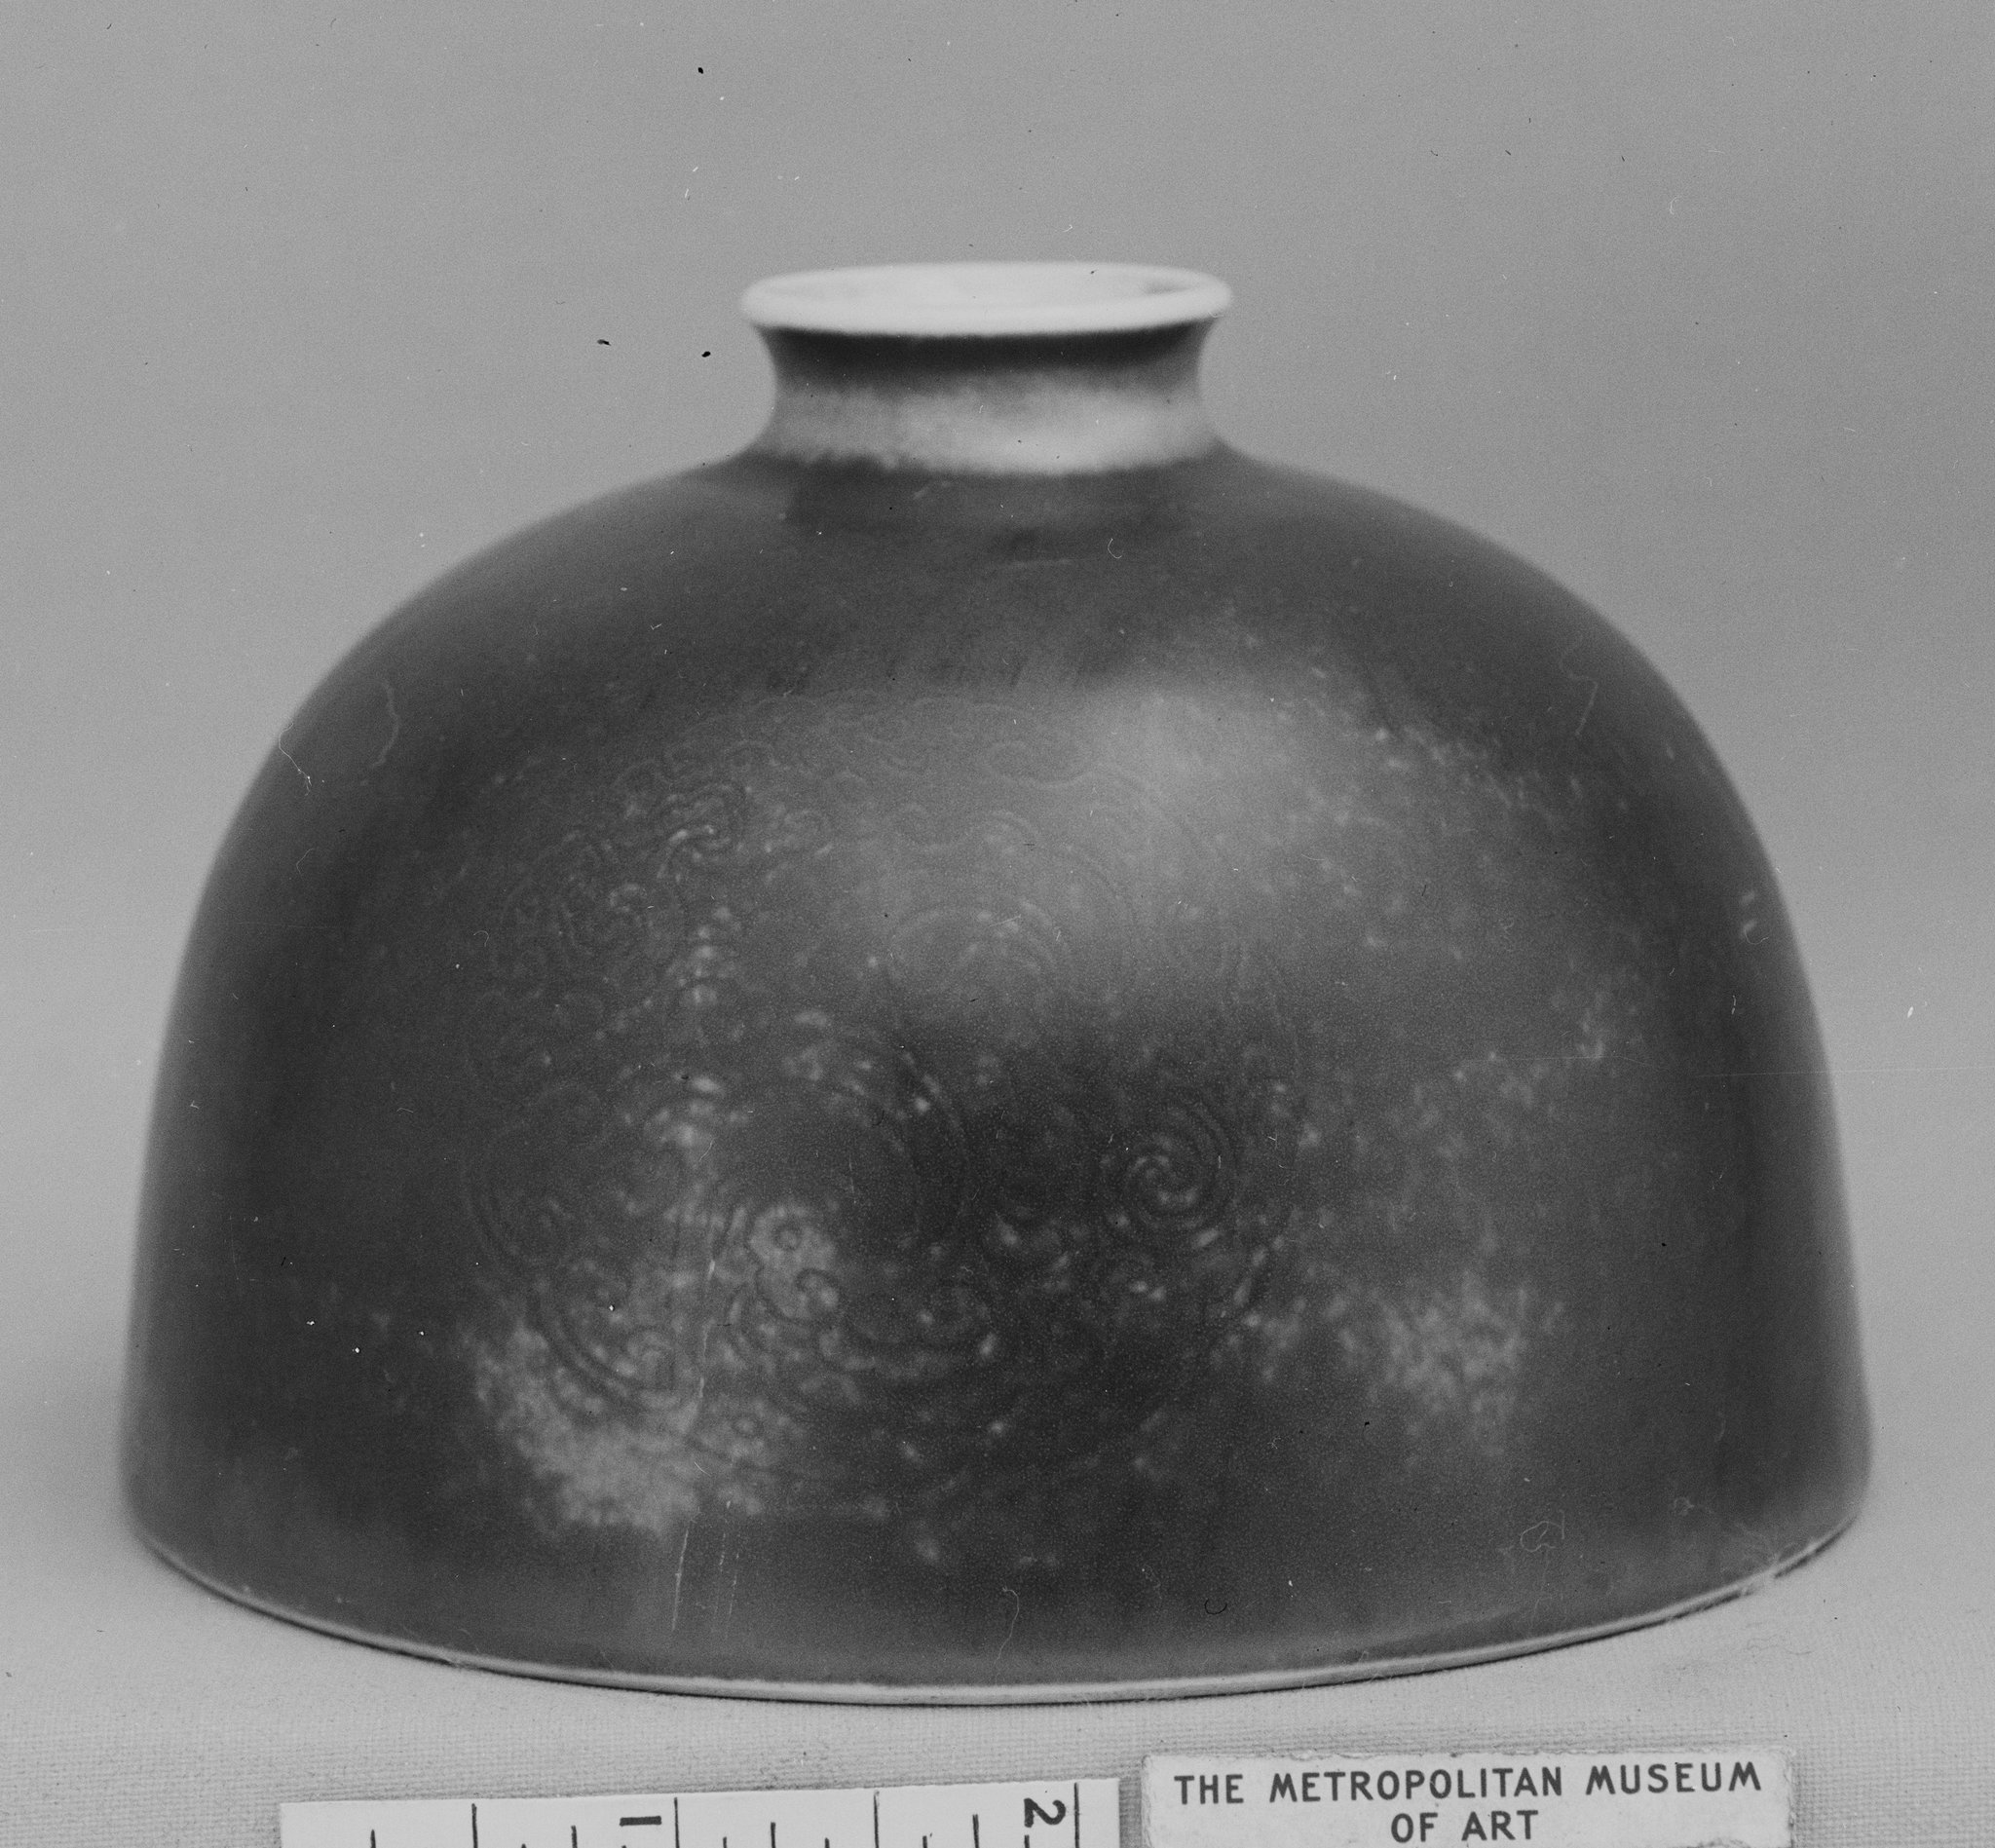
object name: water bottle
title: Writer's Water Bottle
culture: chinese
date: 1662-1722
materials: porcelain